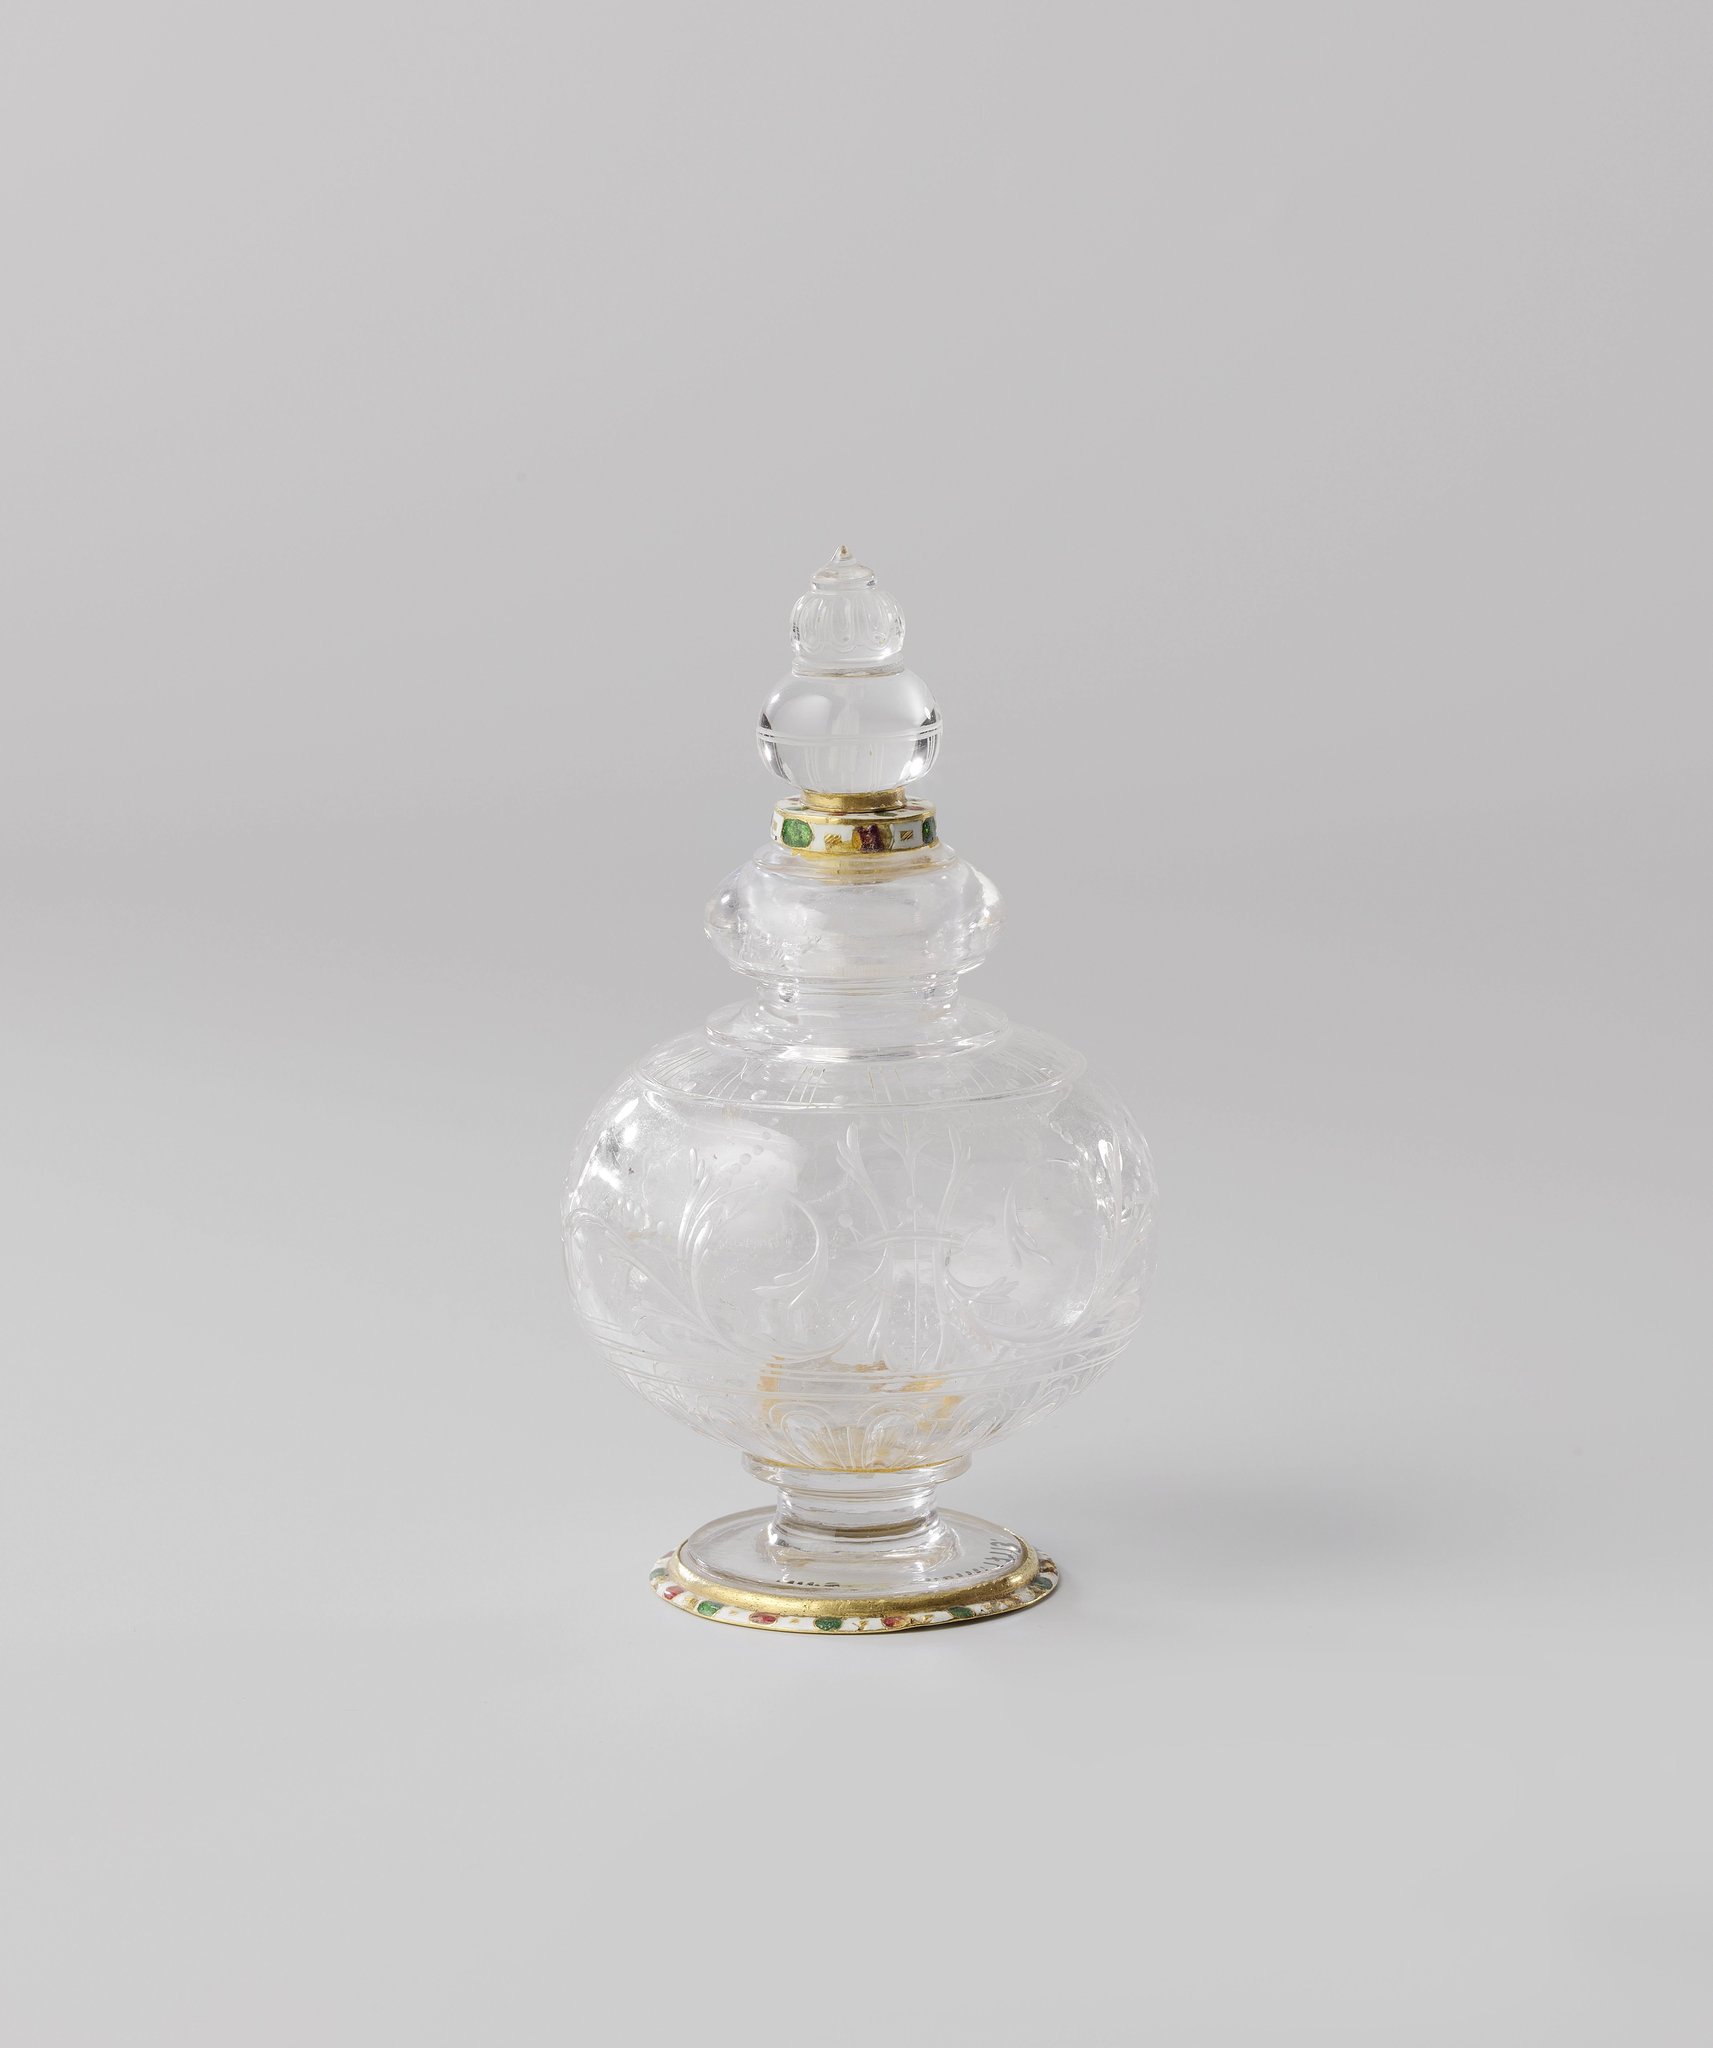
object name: flacon, flakon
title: Flacon van bergkristal met schroefdop. Montuur van goud met veelkleurig email. Versierd met ranken,verbonden door een kroon. Aan de onderkant straalsgewijs geplaatste godrons.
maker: Anonymous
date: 1590-1610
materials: gold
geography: milan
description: Bottle. Rock crystal, gold and enamel. Milan, c. 1600.